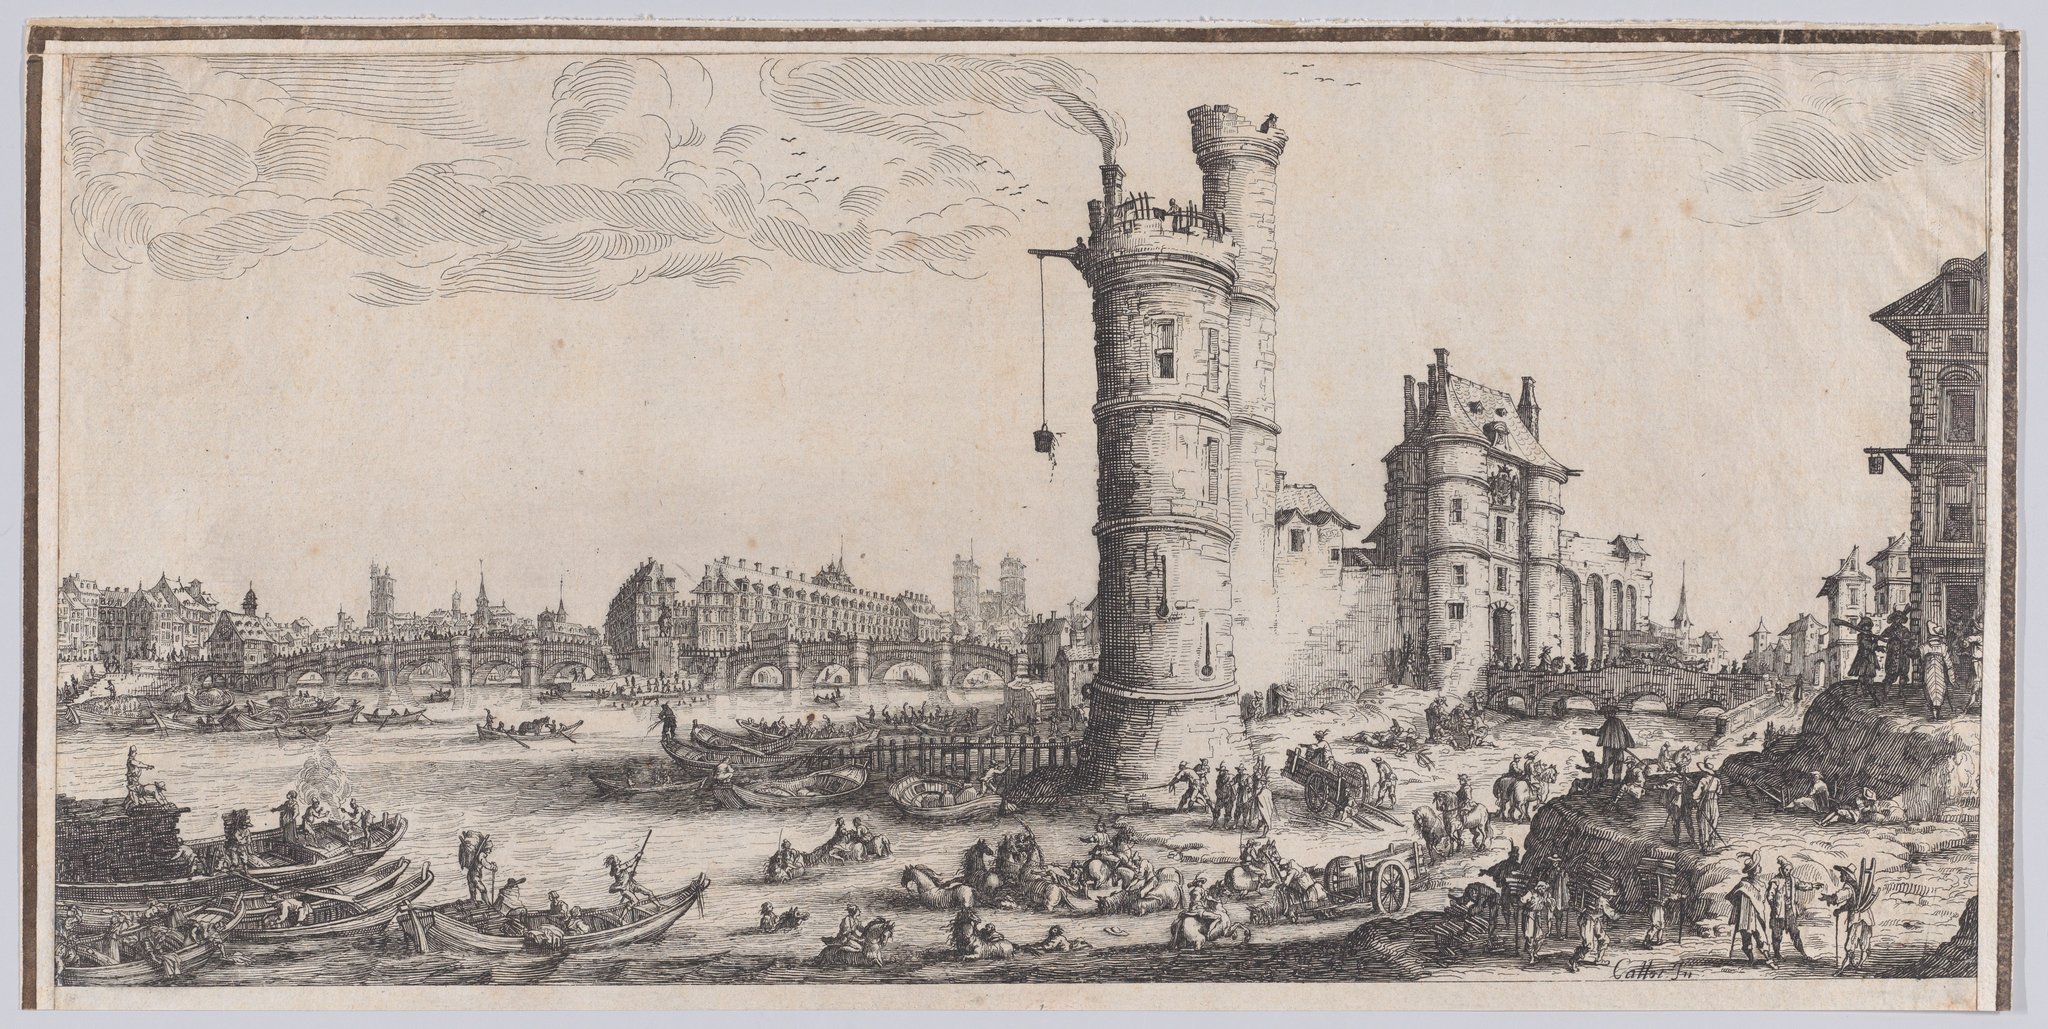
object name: print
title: Copy of Vue du Pont-Neuf (View of the Pont-Neuf), from "Les Deux Grandes Vues de Paris" (The Two Large Views of Paris)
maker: Anonymous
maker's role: artist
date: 1601-1700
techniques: etching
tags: towers,rivers,boats,paris